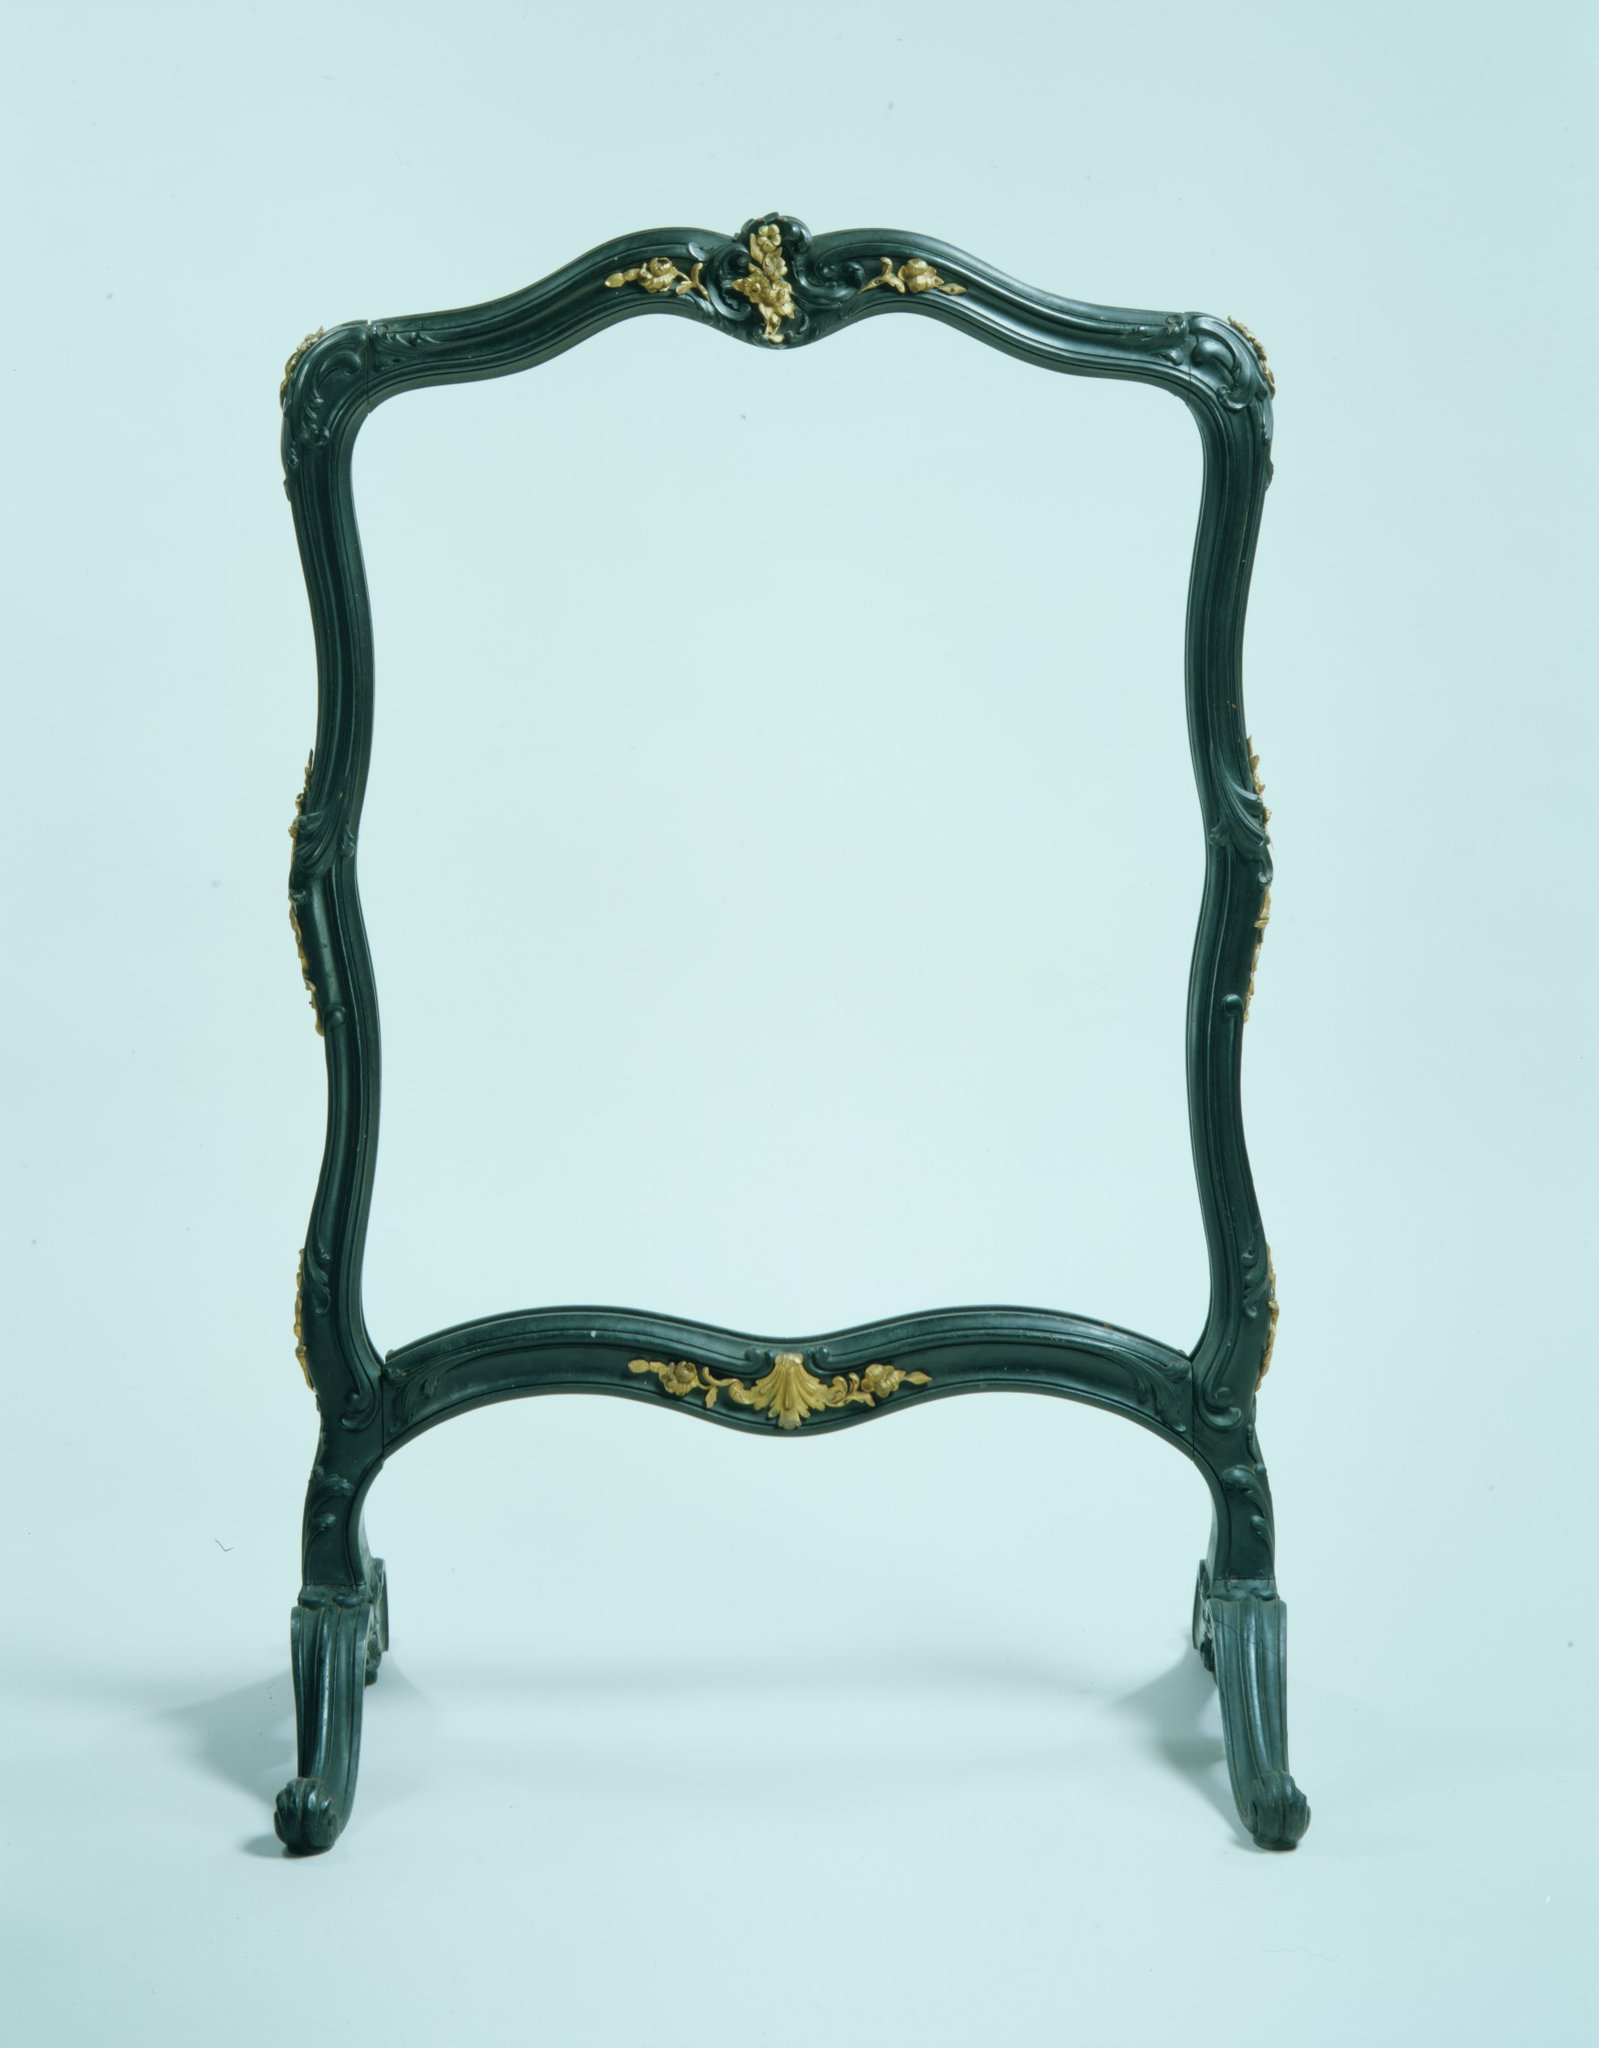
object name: firescreen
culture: american or french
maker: auguste-emile rinquet-leprince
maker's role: maker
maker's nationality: french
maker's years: 1801-1886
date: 1843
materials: wood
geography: france